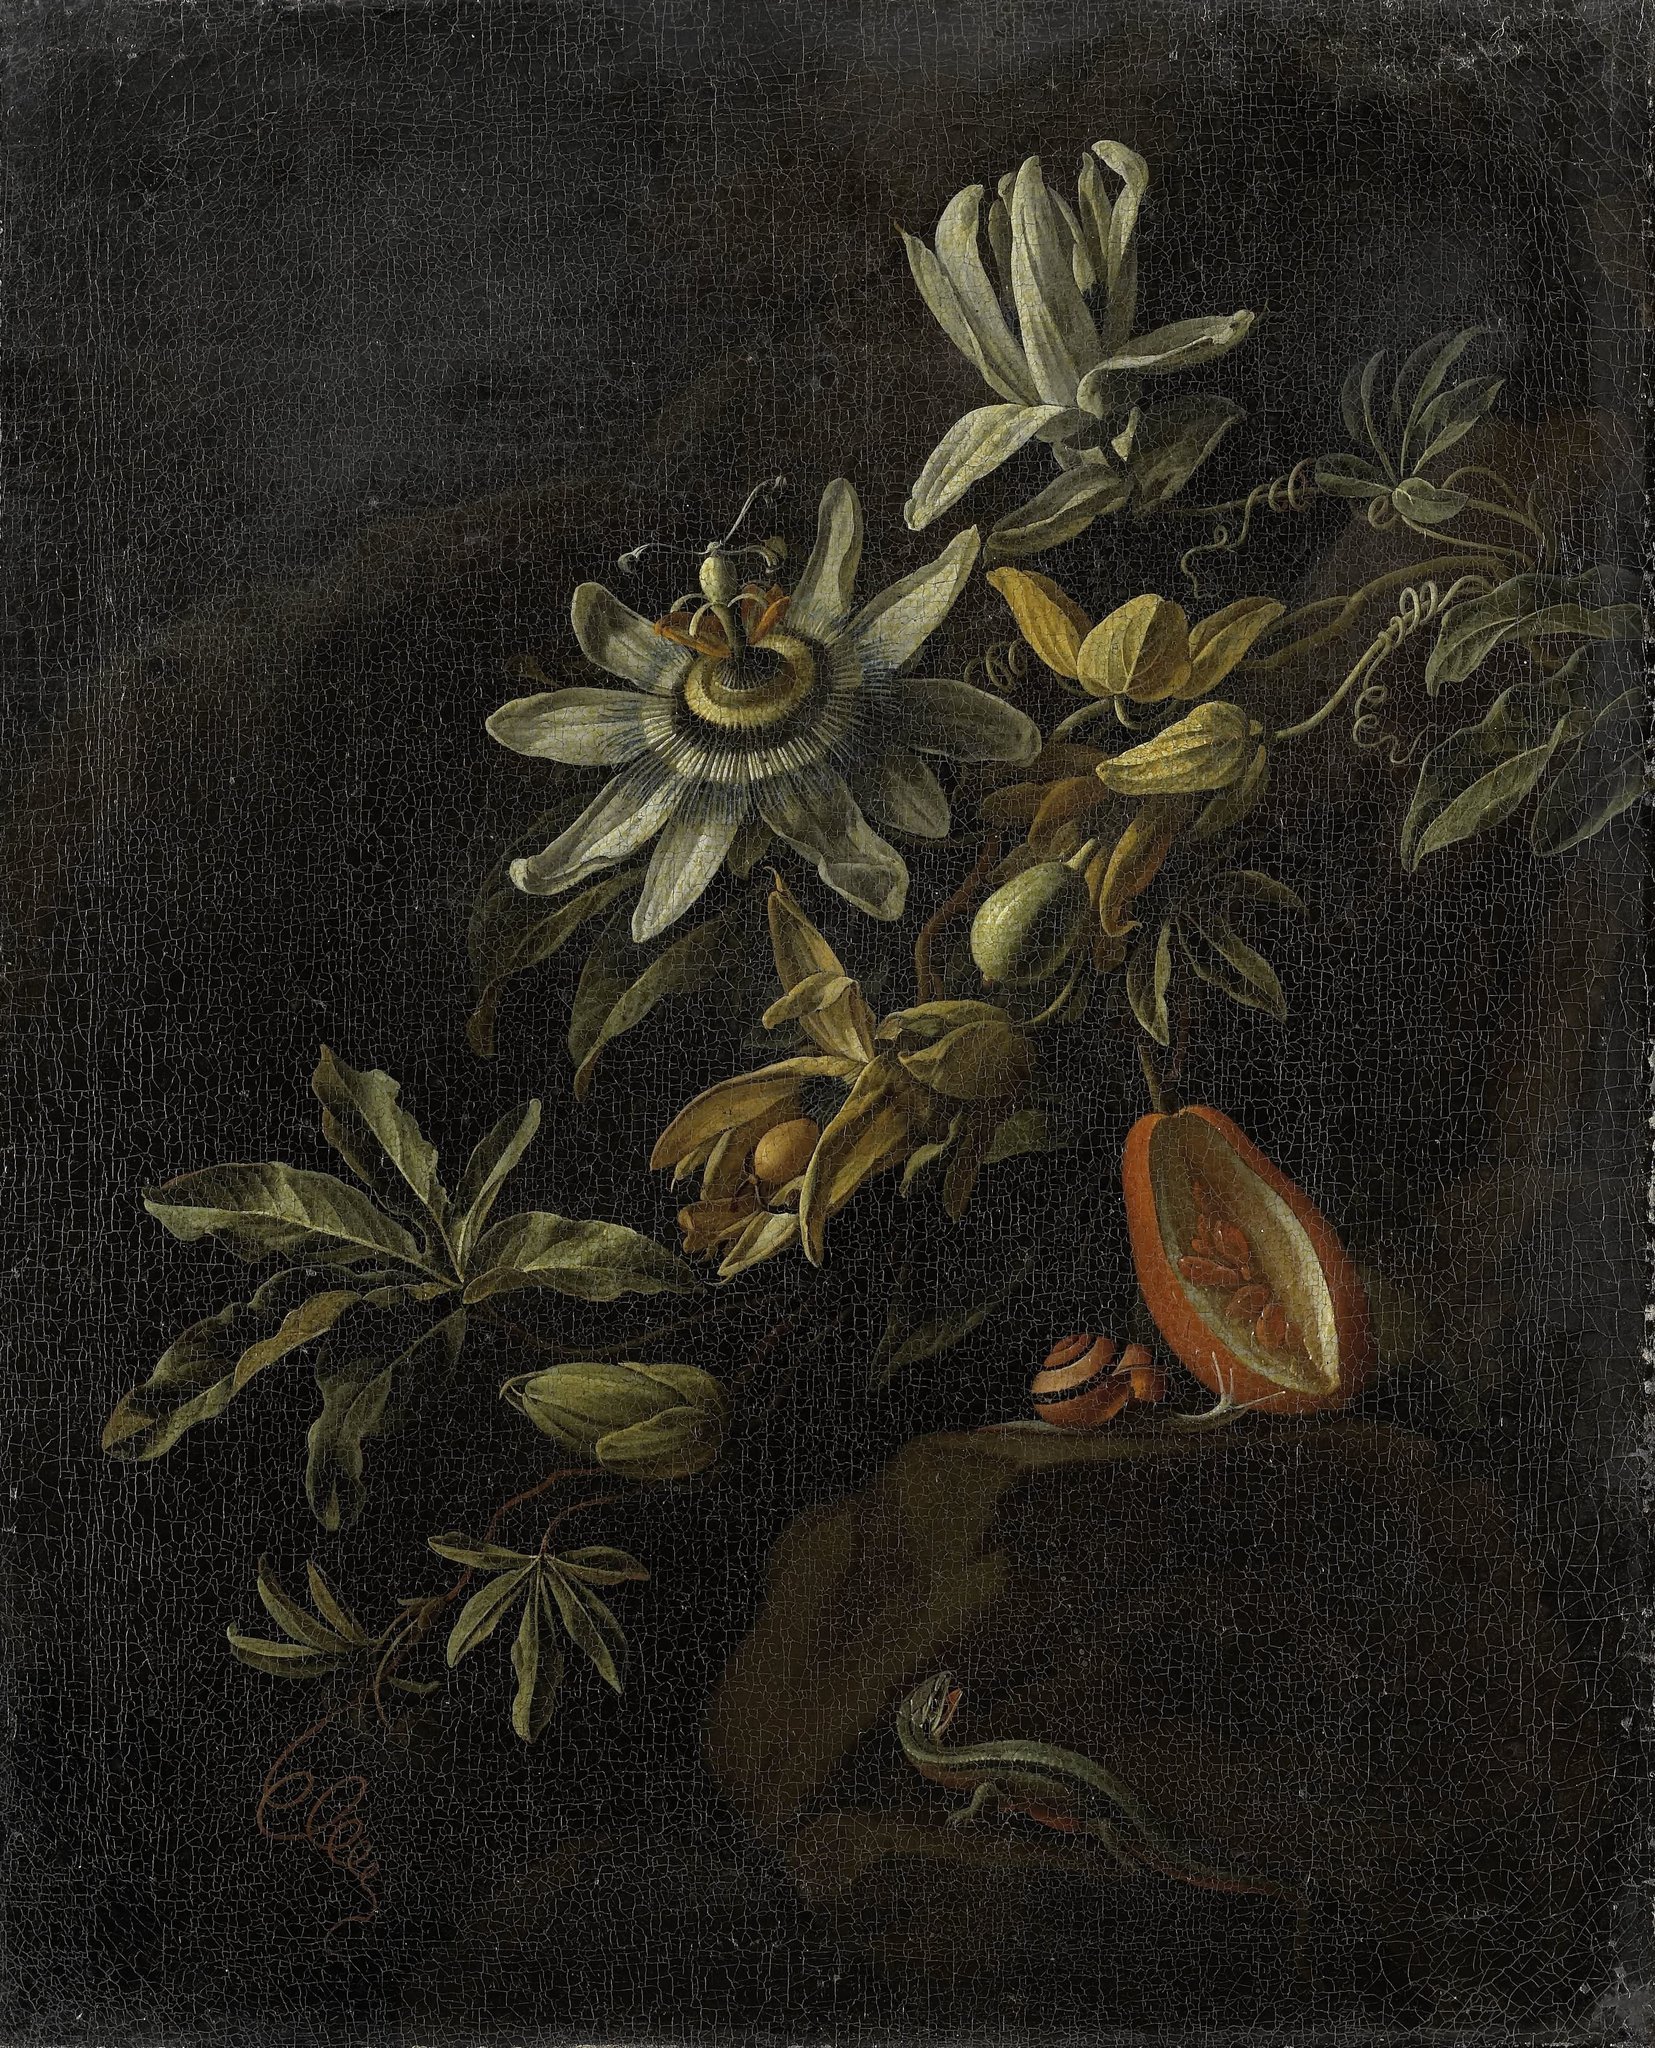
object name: painting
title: Still Life with Passionflowers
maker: elias van den broeck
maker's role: painter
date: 1670-1708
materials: canvas, oil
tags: flowers: passion flower, ornamental plants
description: Stilleven met passiebloemen en passievruchten, waarbij ook een hagedis en een slak.